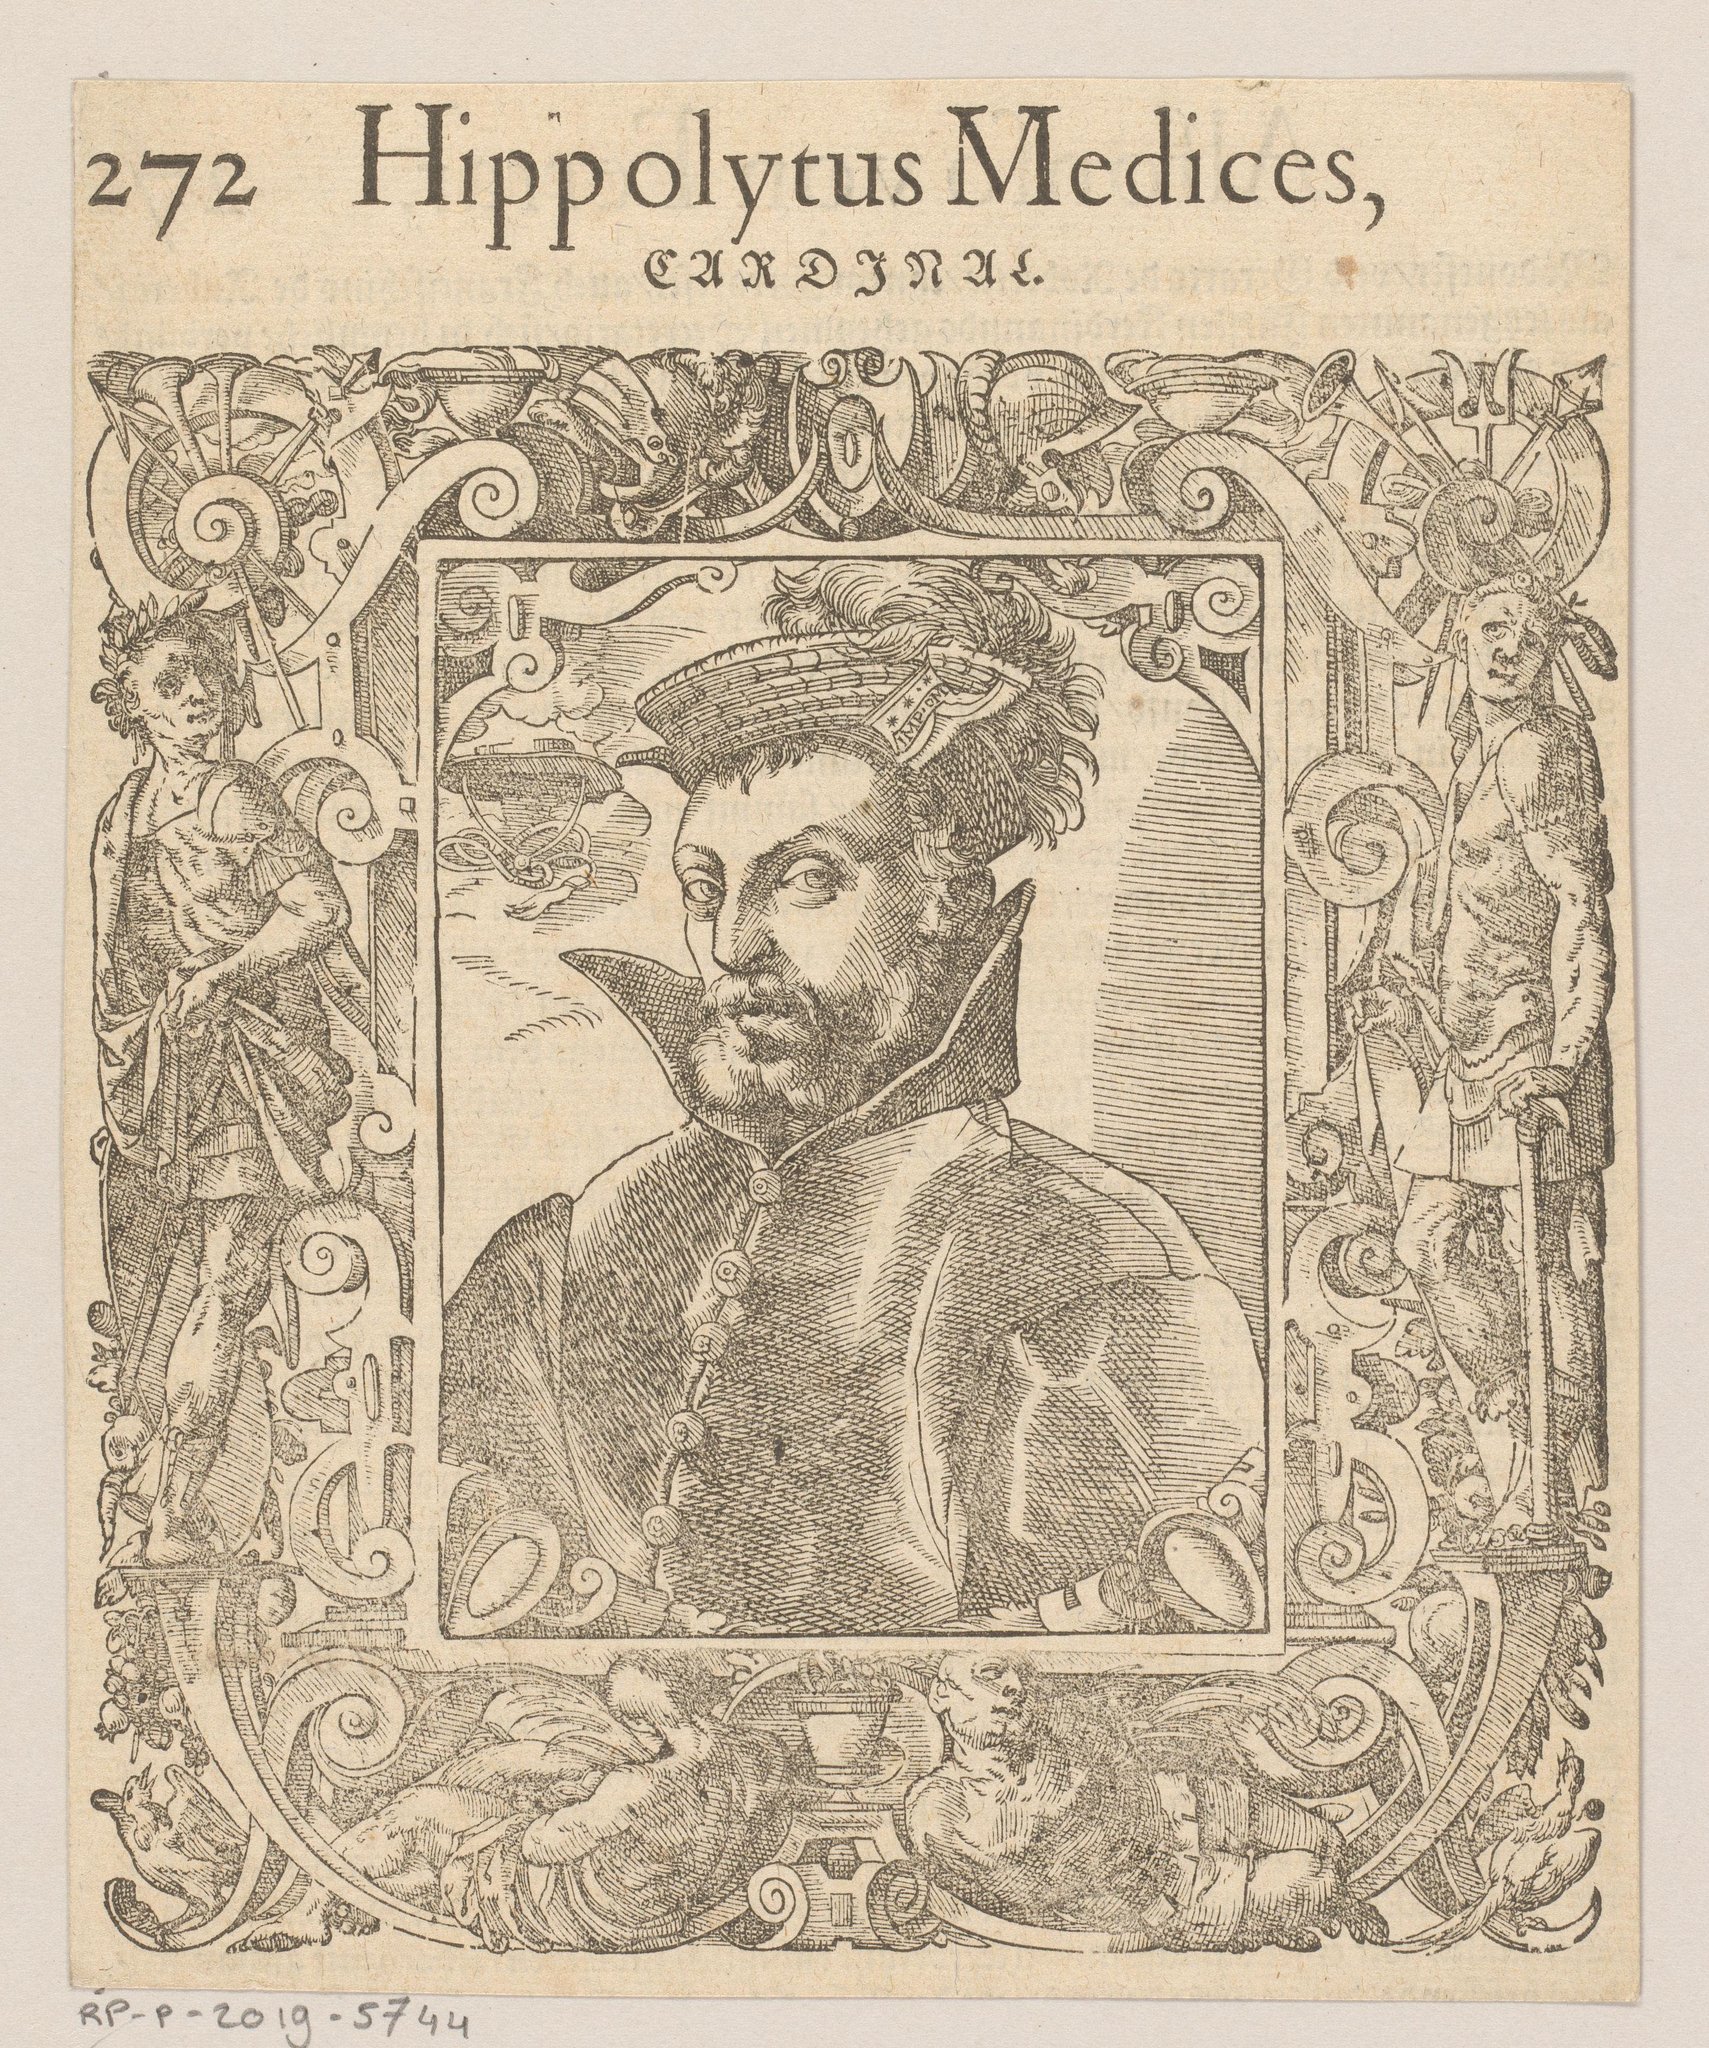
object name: print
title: Portret van Ippolito de' Medici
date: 1587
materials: paper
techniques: letterpress printing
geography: basel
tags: priest, historical persons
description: Prent uit: Warhafftiger kurtzer Bericht von mannigerley Kriegs und anderen fürnemen (...). Bazel: Konrad Waldkirch, 1587, p. 272. Prent eerder verschenen in: Giovio, Paolo. Elogia virorum bellica virtute illustrium (...). Bazel: Peter Perna, 1575. Prent mogelijk ook gebruikt in latere publicaties.